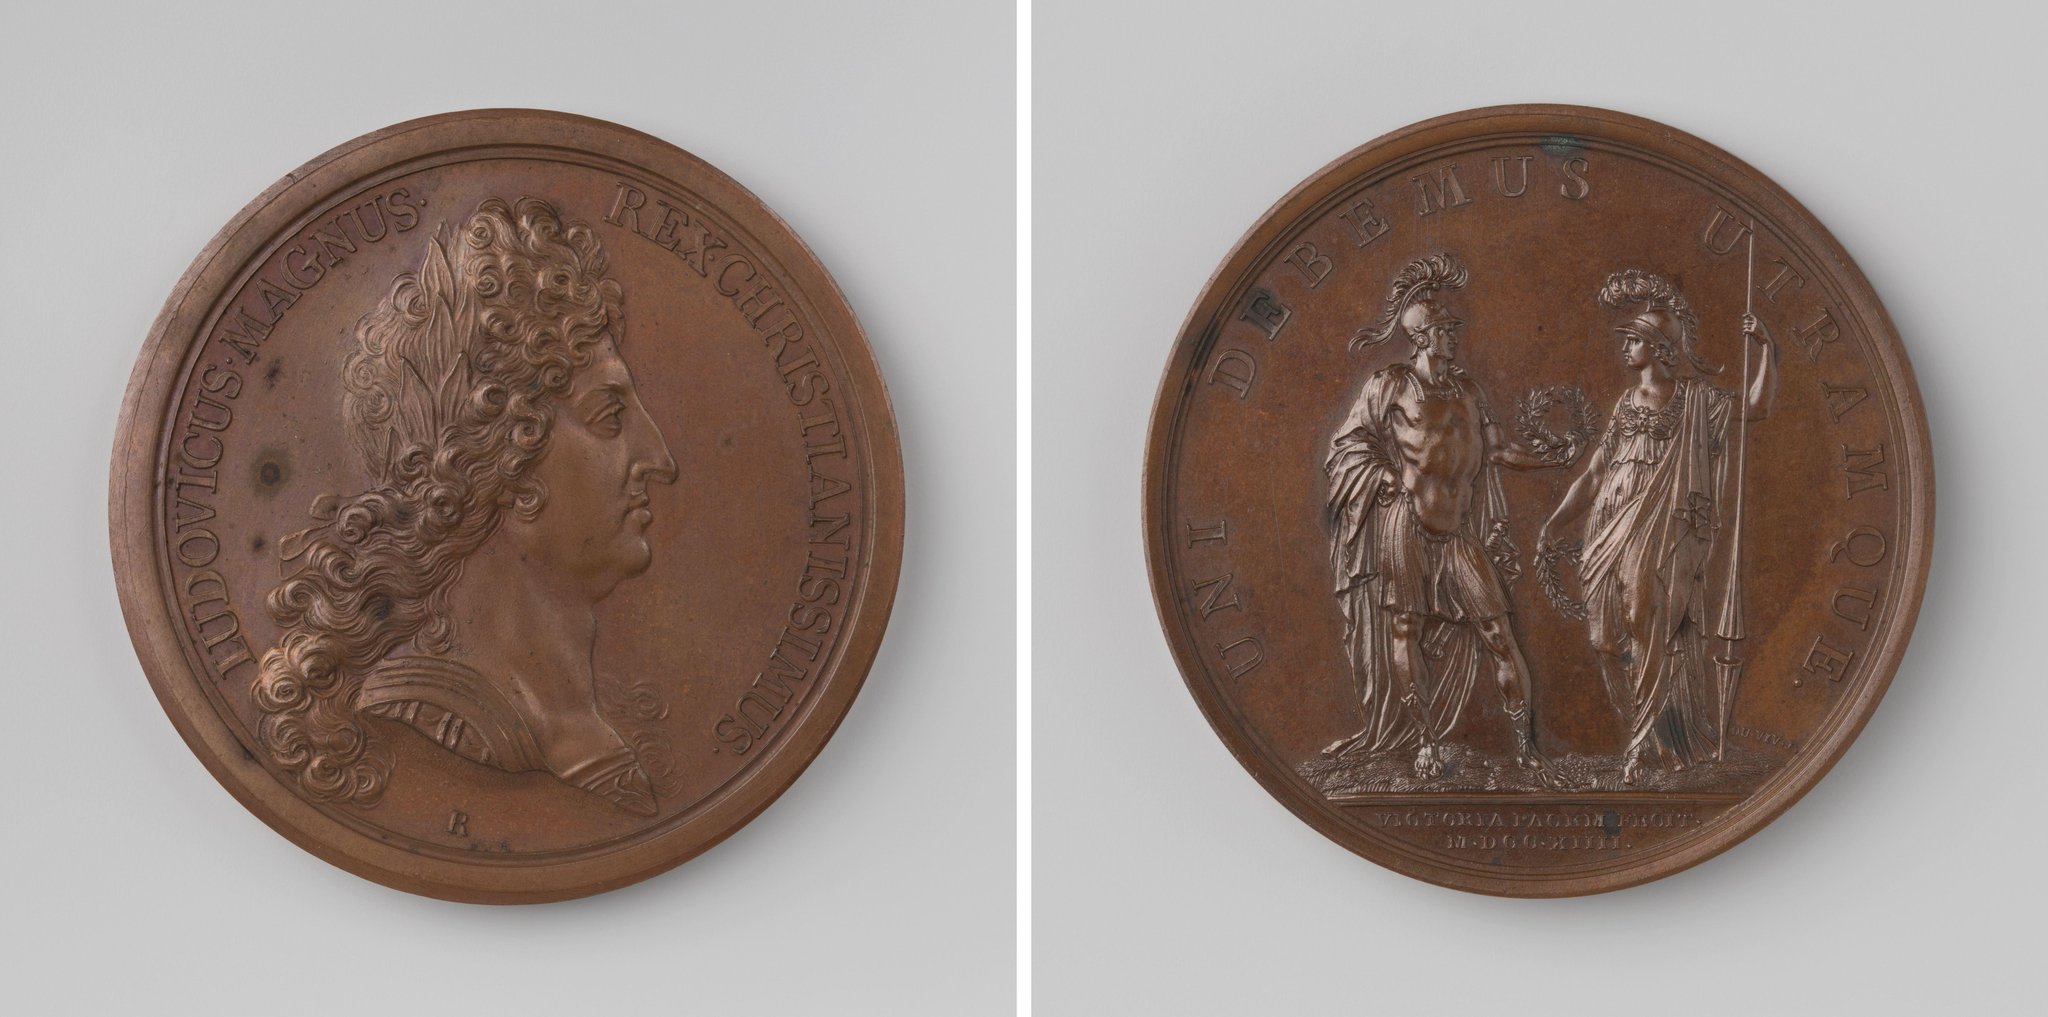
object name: history medal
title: Vrede van Rastatt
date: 1714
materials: bronze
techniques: striking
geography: paris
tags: lodewijk xiv (koning van frankrijk)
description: Bronzen penning. Voorzijde: borststuk man met lauwerkrans binnen omschrift. Keerzijde: Mars en pallas Athene met speer houden ieder een lauwerkrans in handen binnen omschrift; afsnede: opschrift